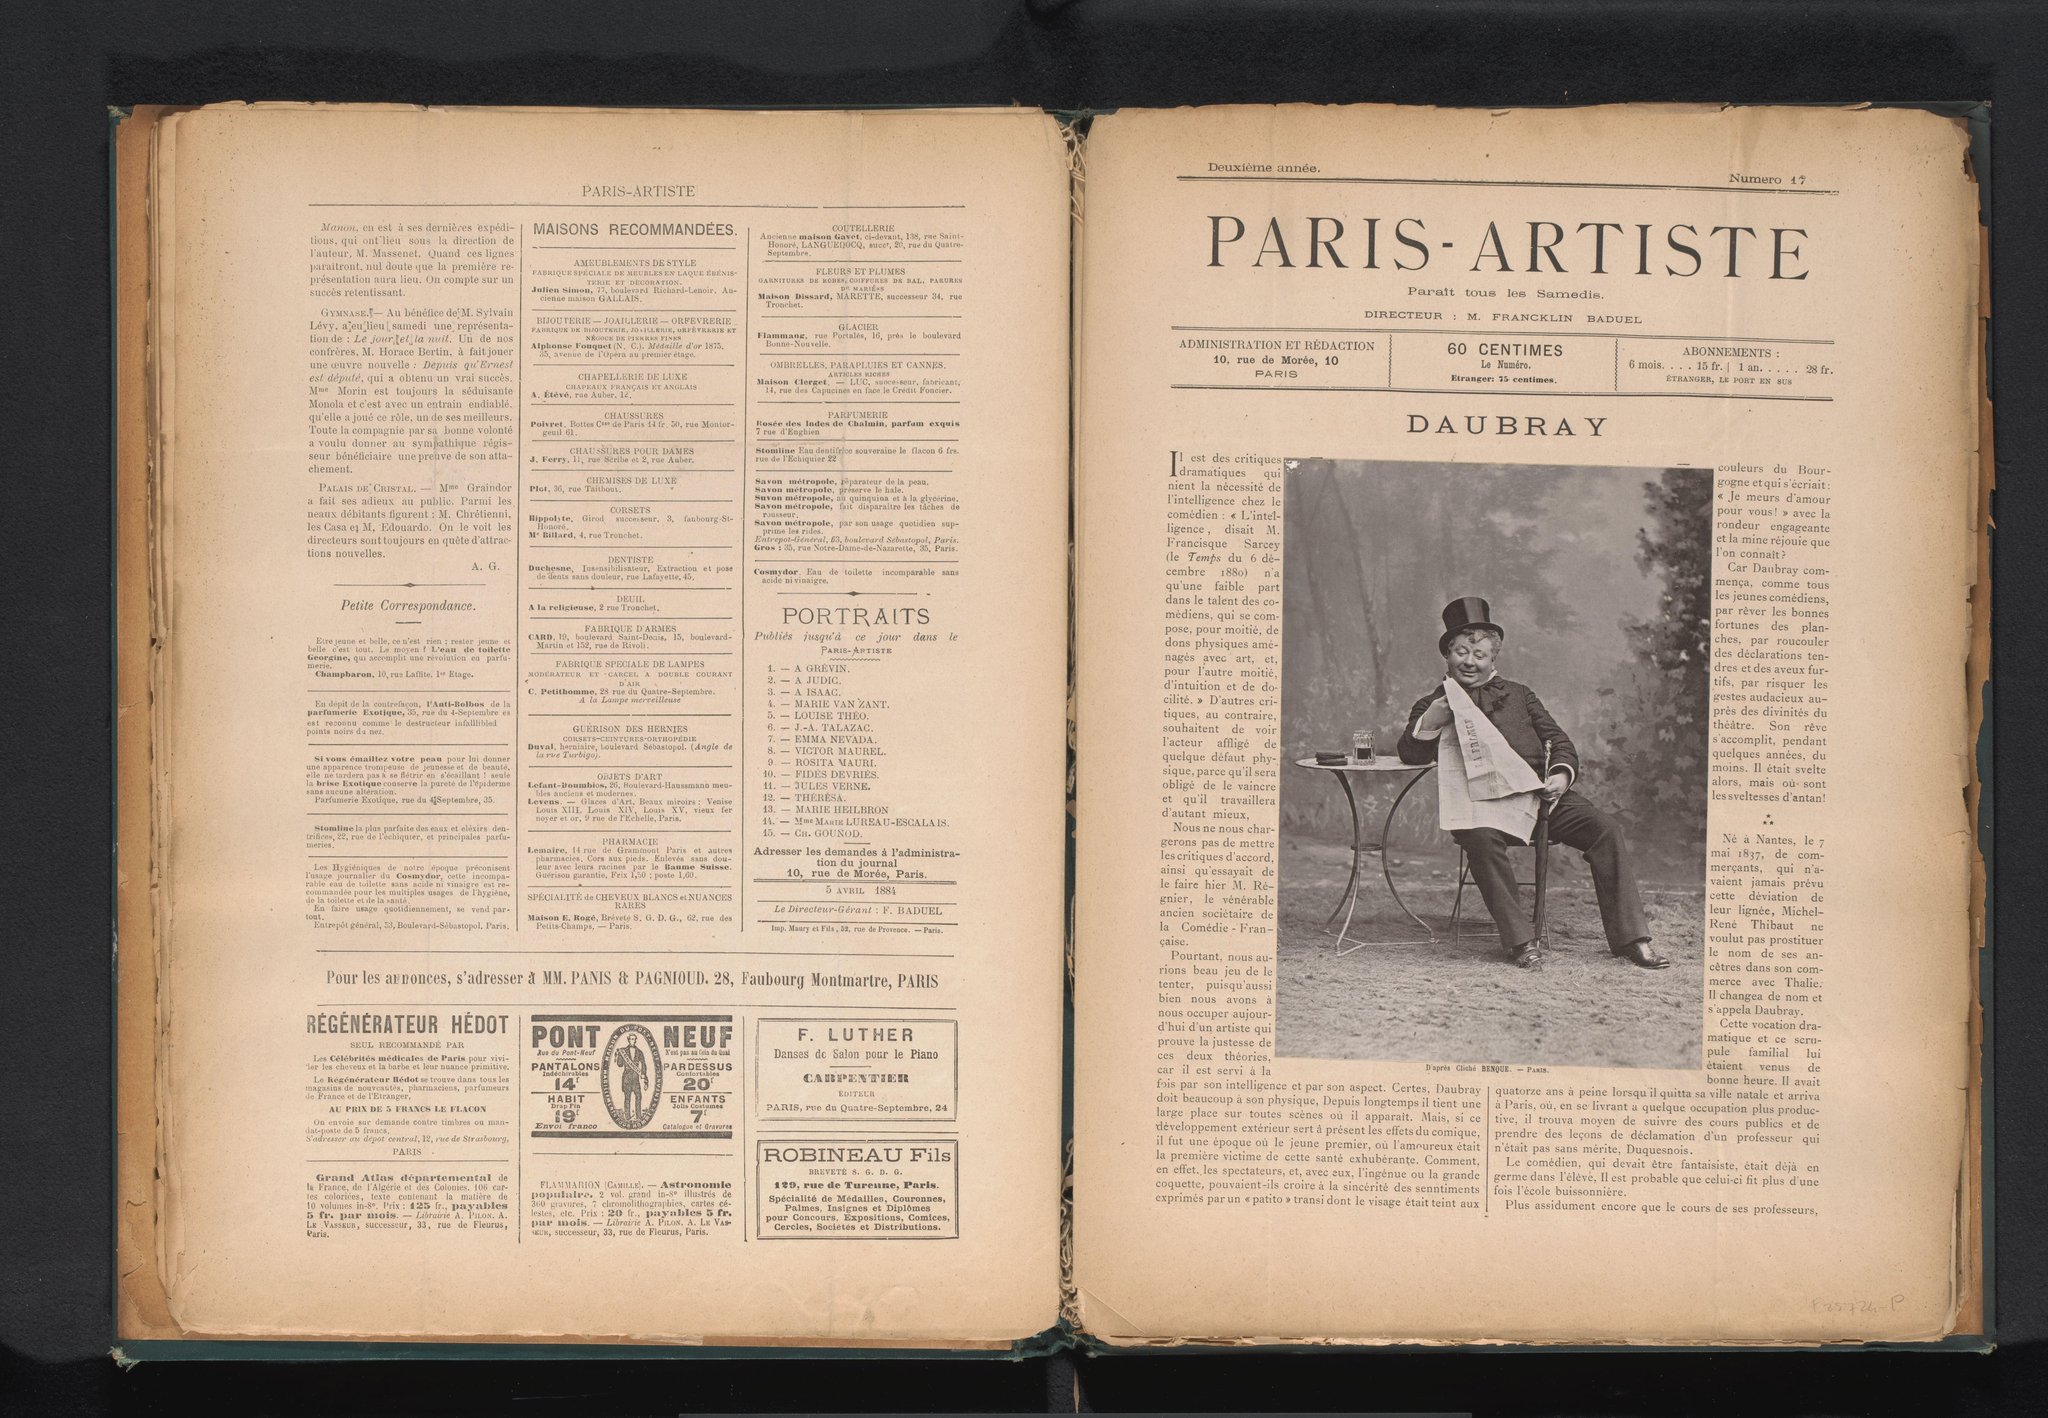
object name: photomechanical print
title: Portret van Daubray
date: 1875-1884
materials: paper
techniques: photograph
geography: paris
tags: reading, historical persons, portrait of actor, actress